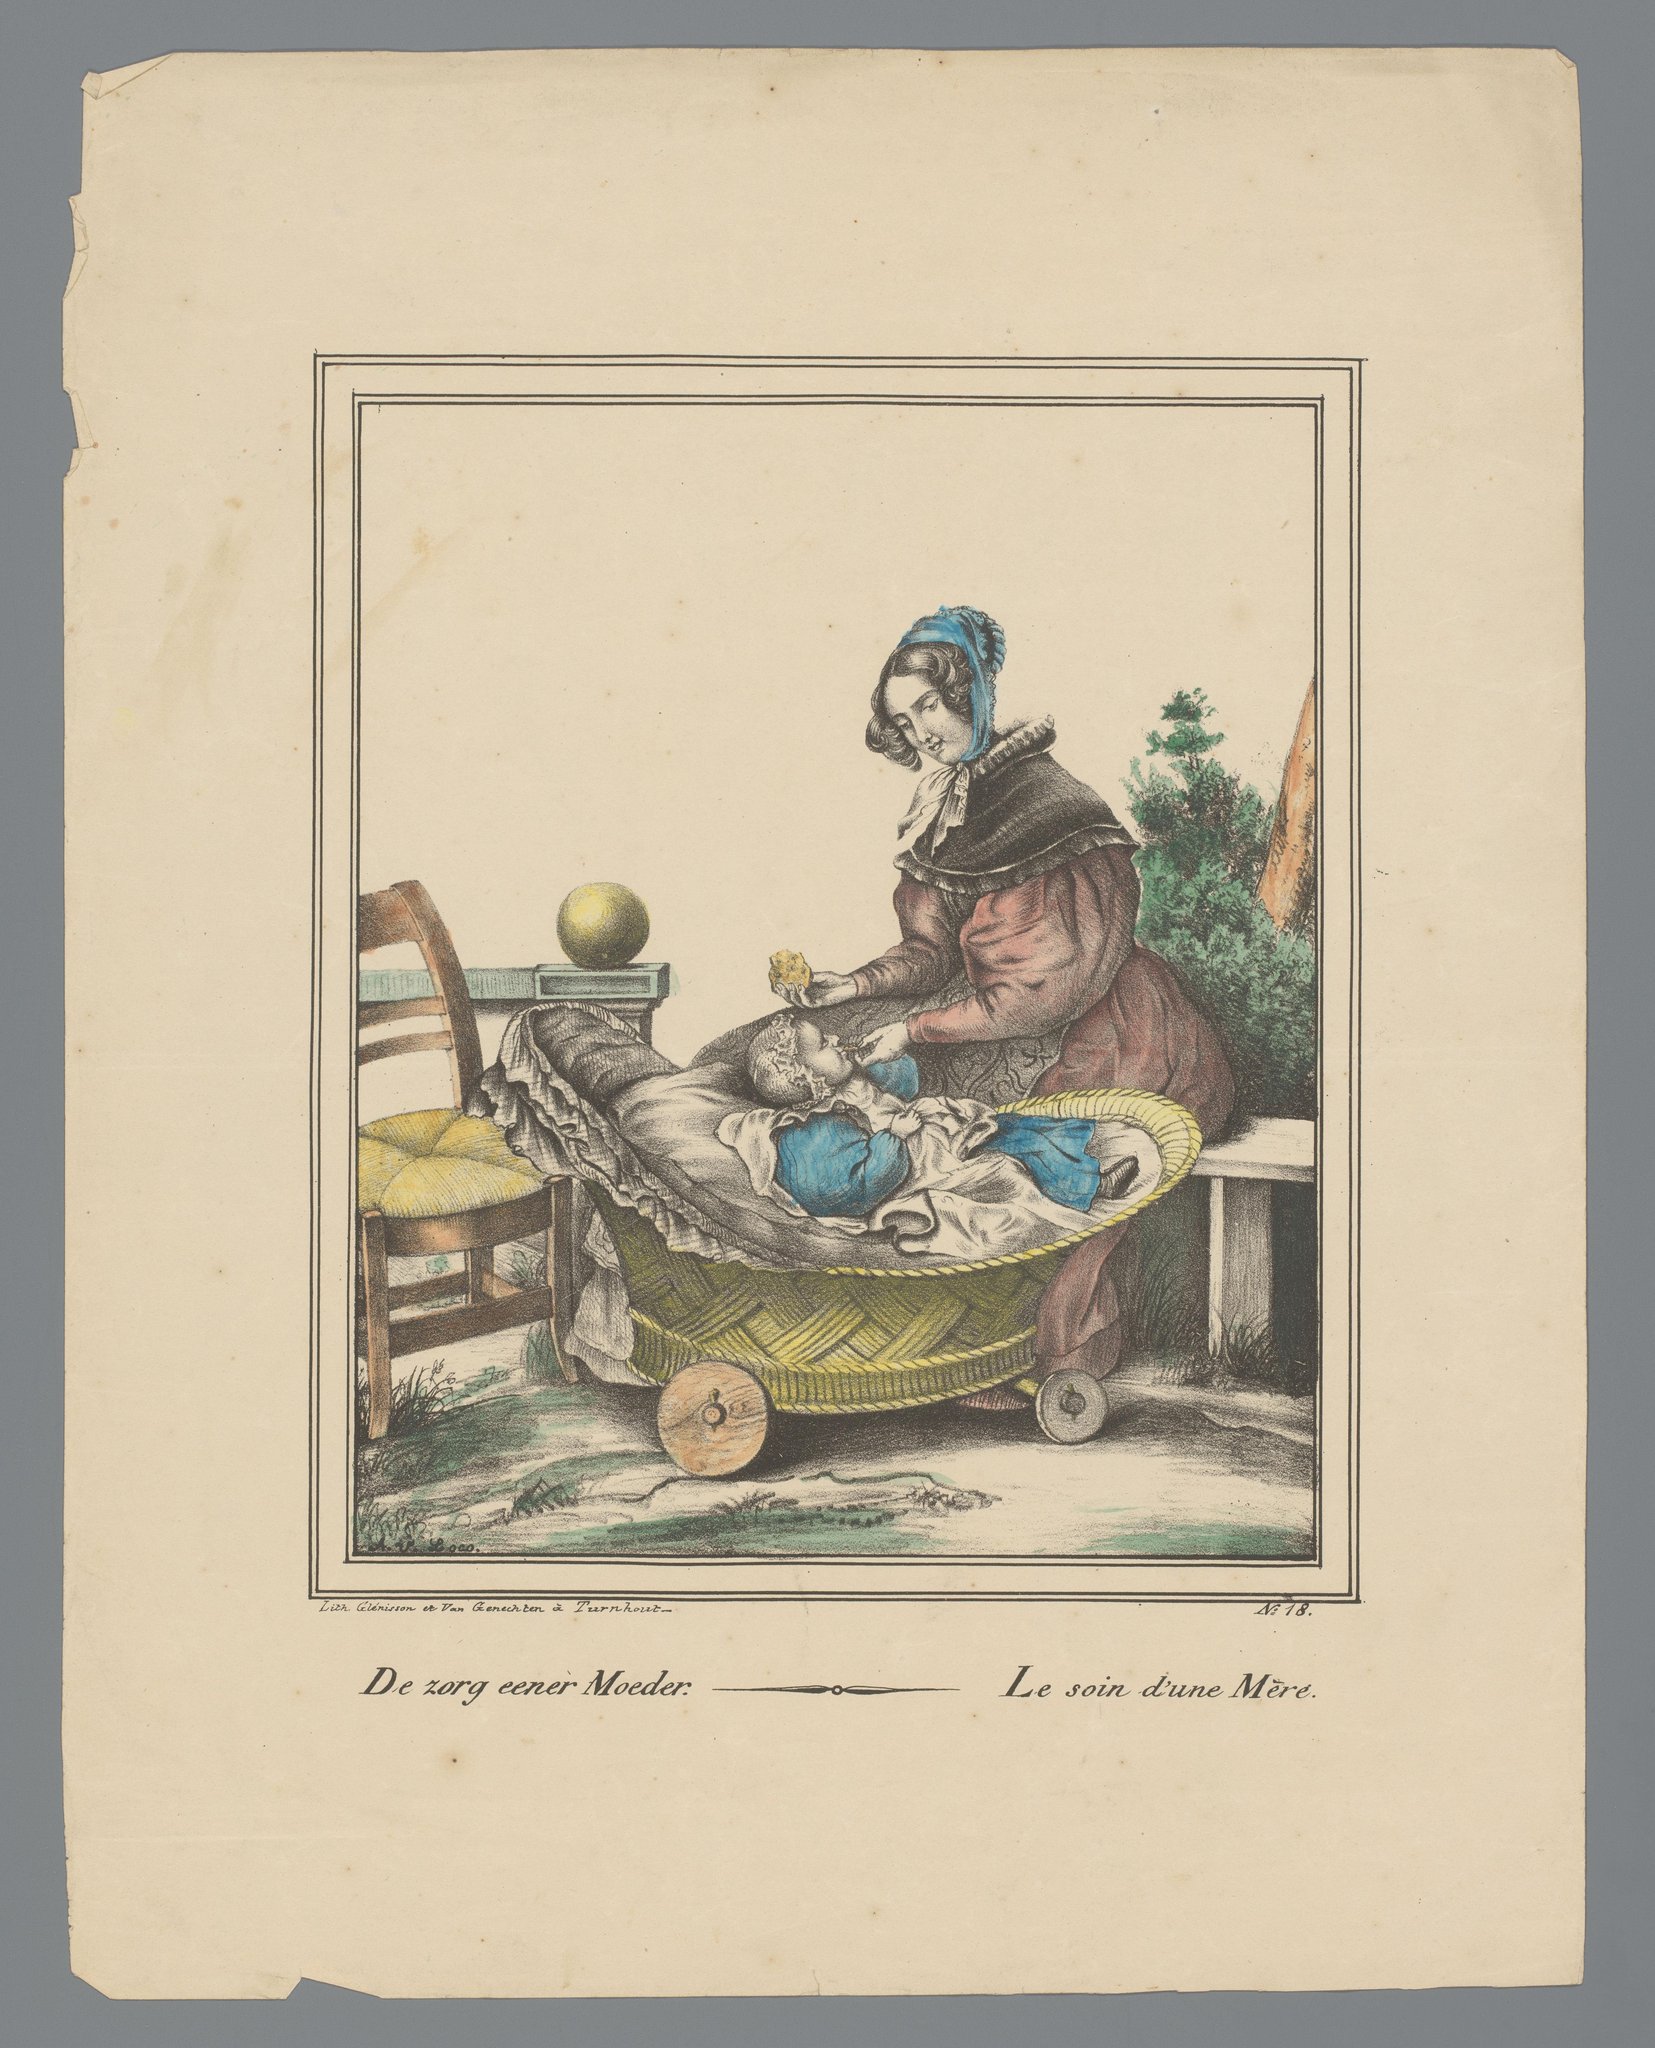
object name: print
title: Moeder geeft kind in kinderwagen te eten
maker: a. van loco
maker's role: print maker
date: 1837-1856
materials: paper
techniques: hand coloring, lithograph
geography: turnhout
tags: baby-carriage, pram, perambulator, feeding a baby, mother and baby or young child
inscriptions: collector's mark: Lugt 2233